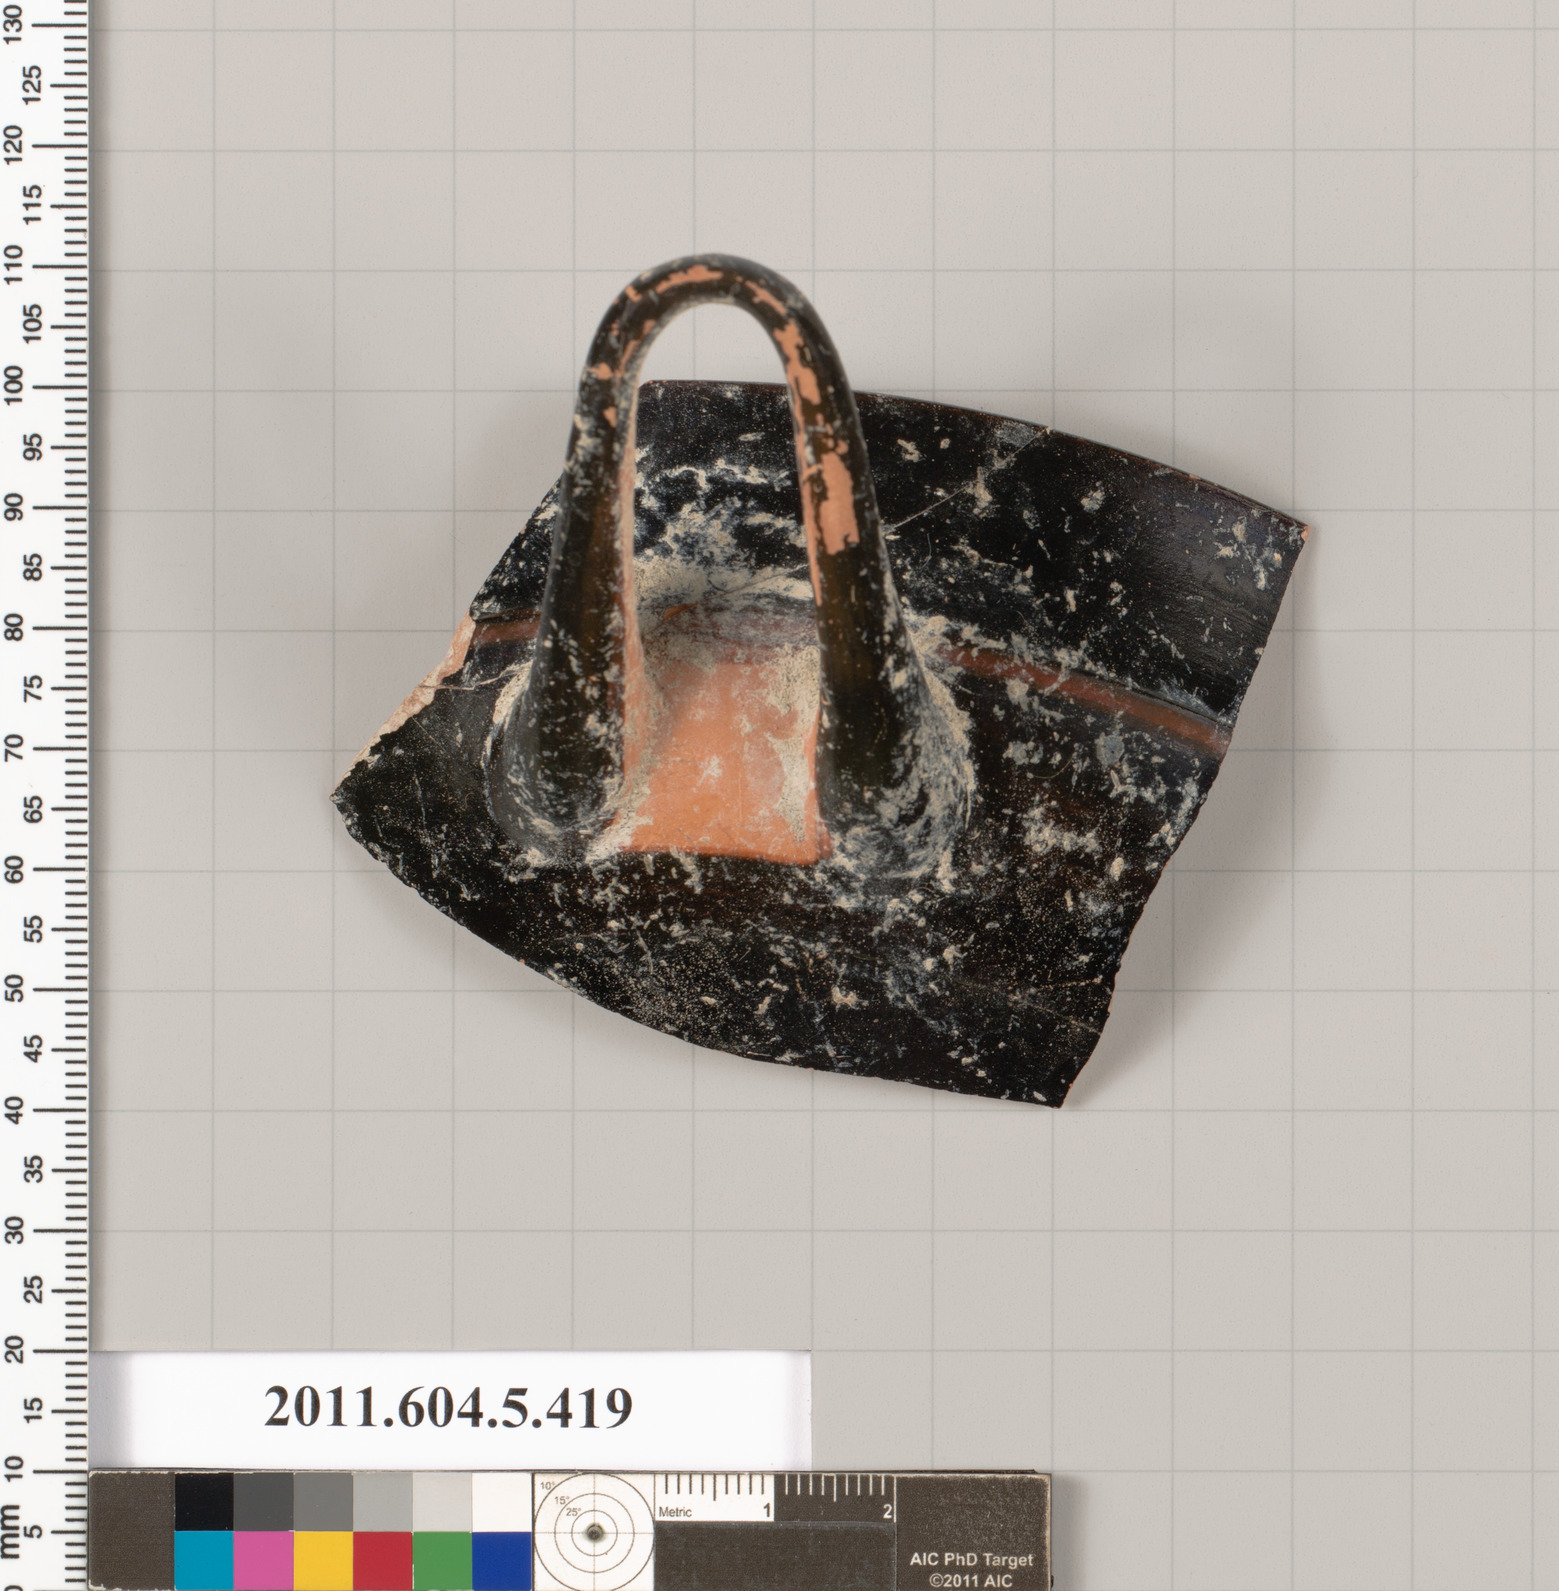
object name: kylix fragment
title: Terracotta rim fragment of a kylix (drinking cup)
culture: greek, attic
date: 500-401 BCE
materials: terracotta